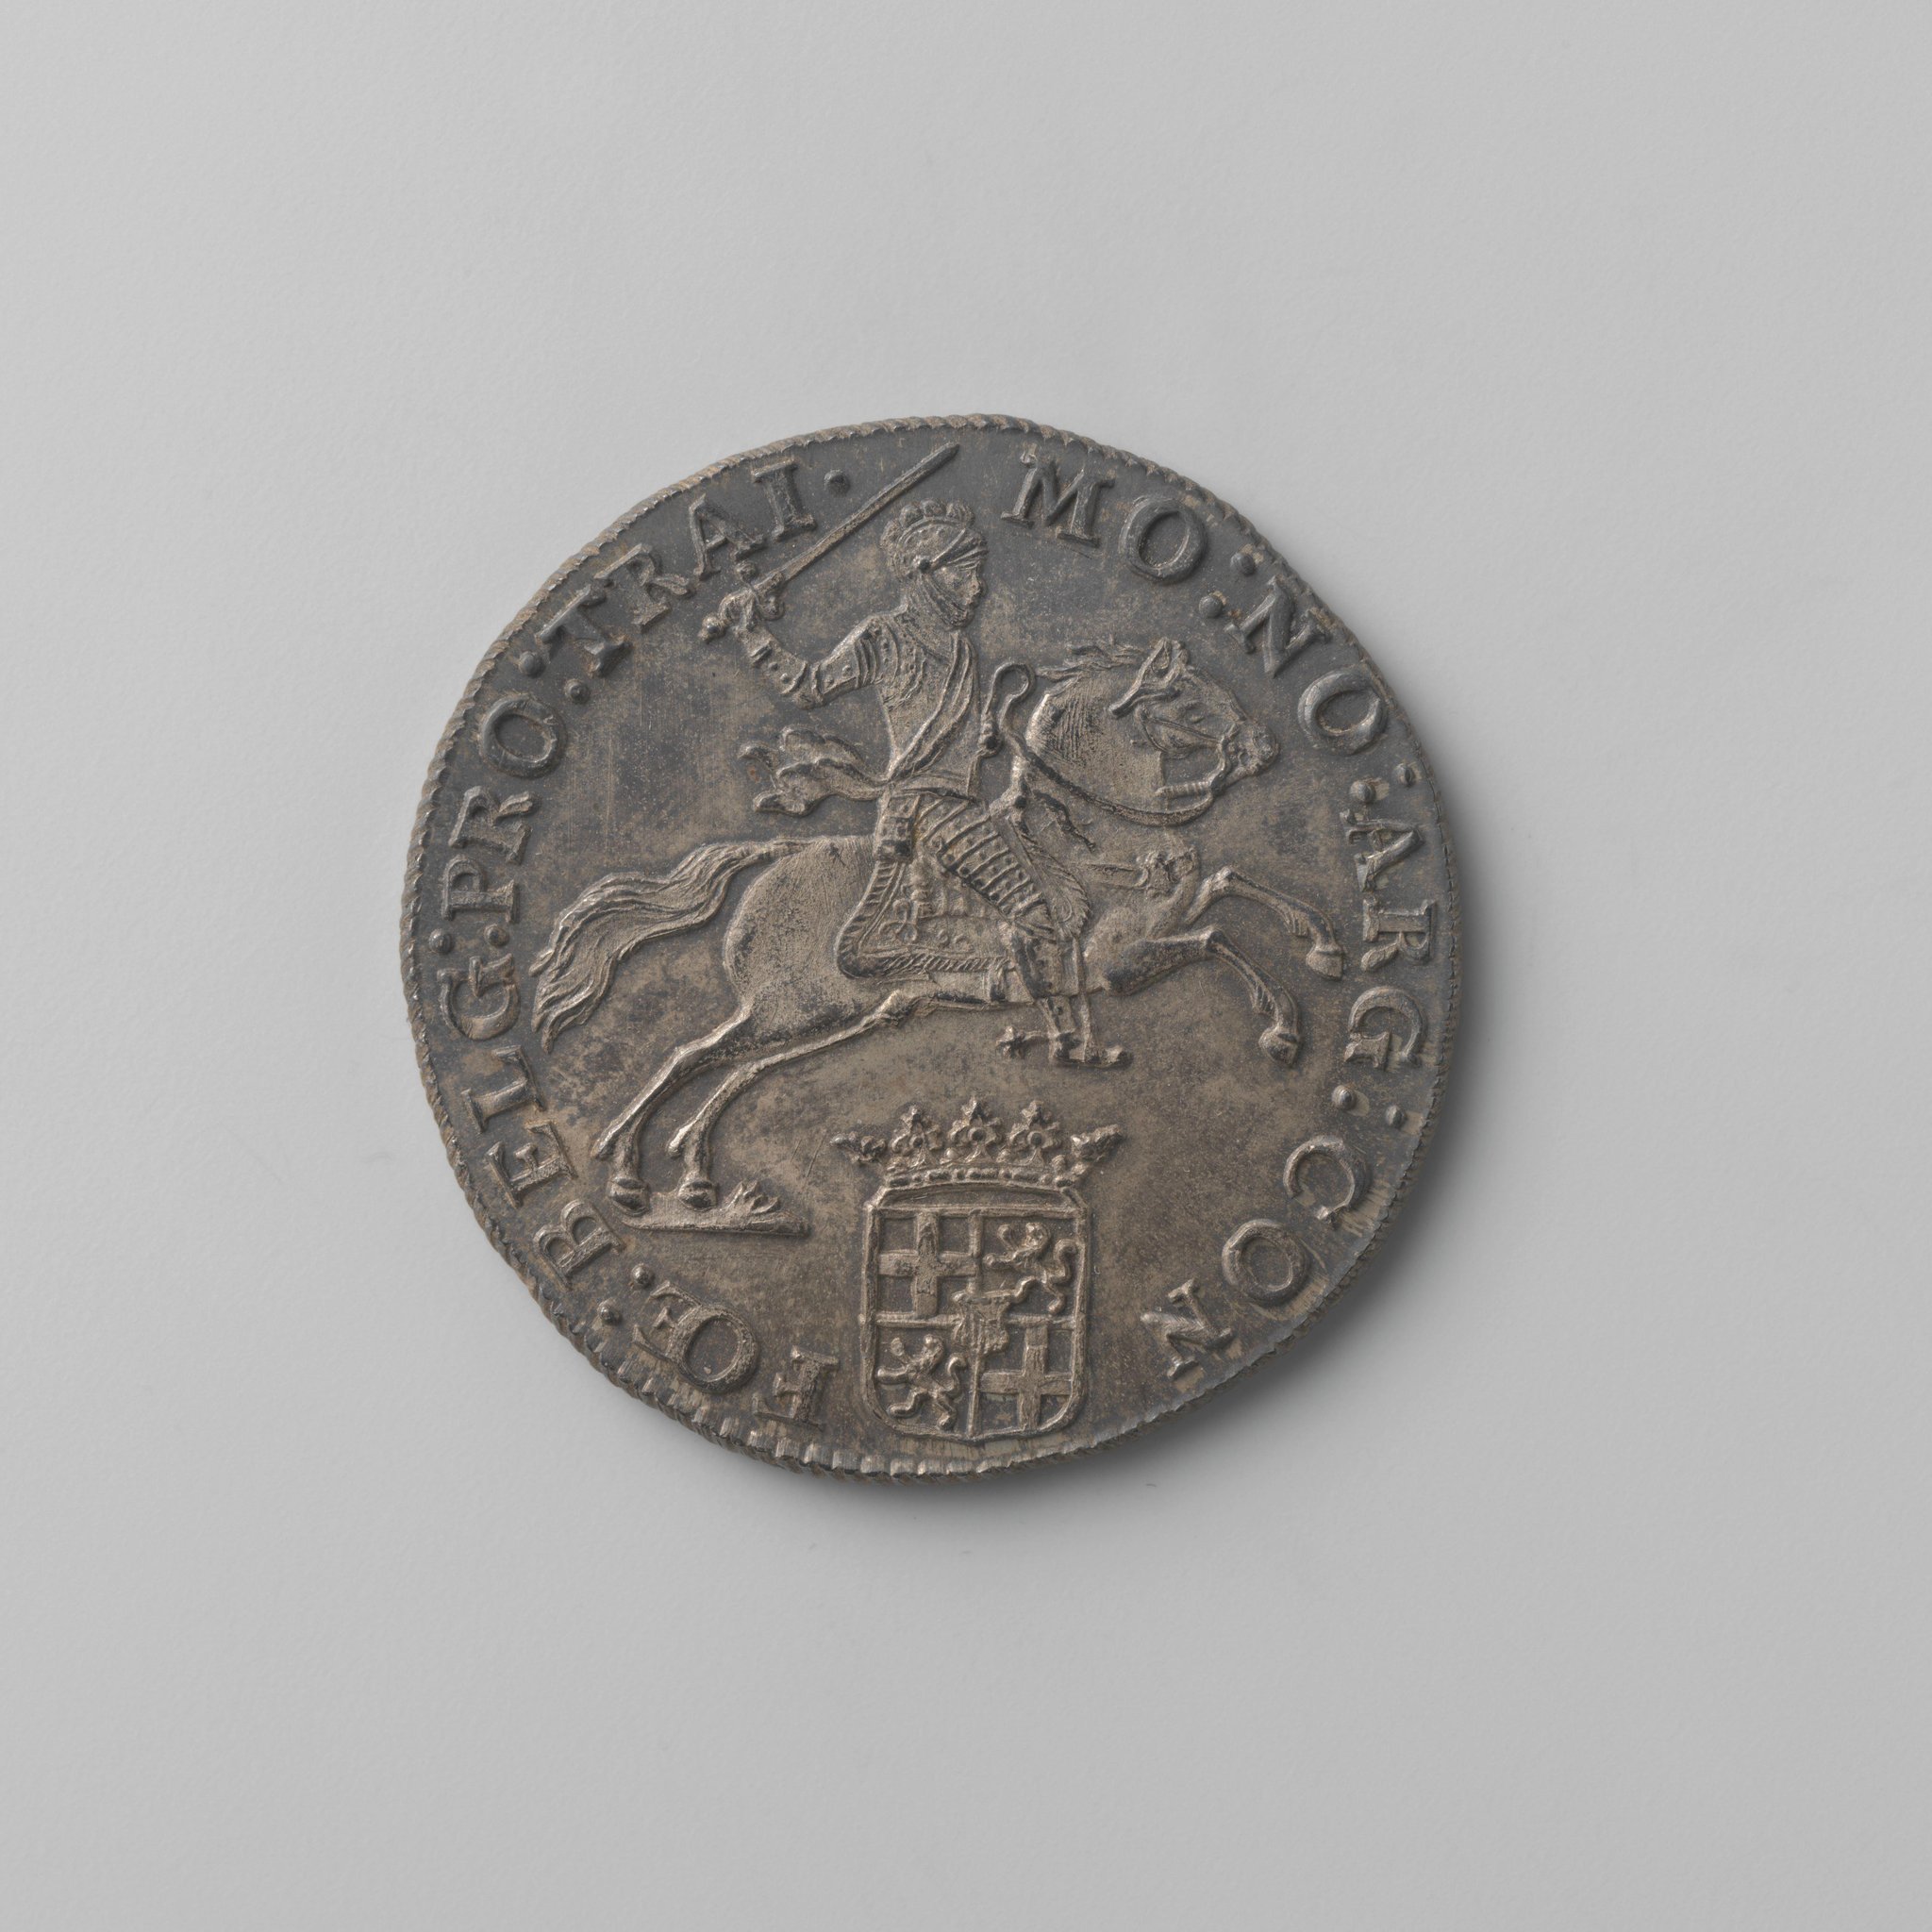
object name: coin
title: Utrecht, halve zilveren rijder, 1793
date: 1793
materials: silver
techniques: striking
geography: utrecht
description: Zilveren munt. Voorzijde: ridder te paard naar rechts met in rechterhand zwaard. Onder paard gekroond wapenschild van Utrecht. Keerzijde: door twee gekroonde leeuwen gehouden generaliteitswapenschild. Daaronder in cartouche jaartal. Kabelrand.